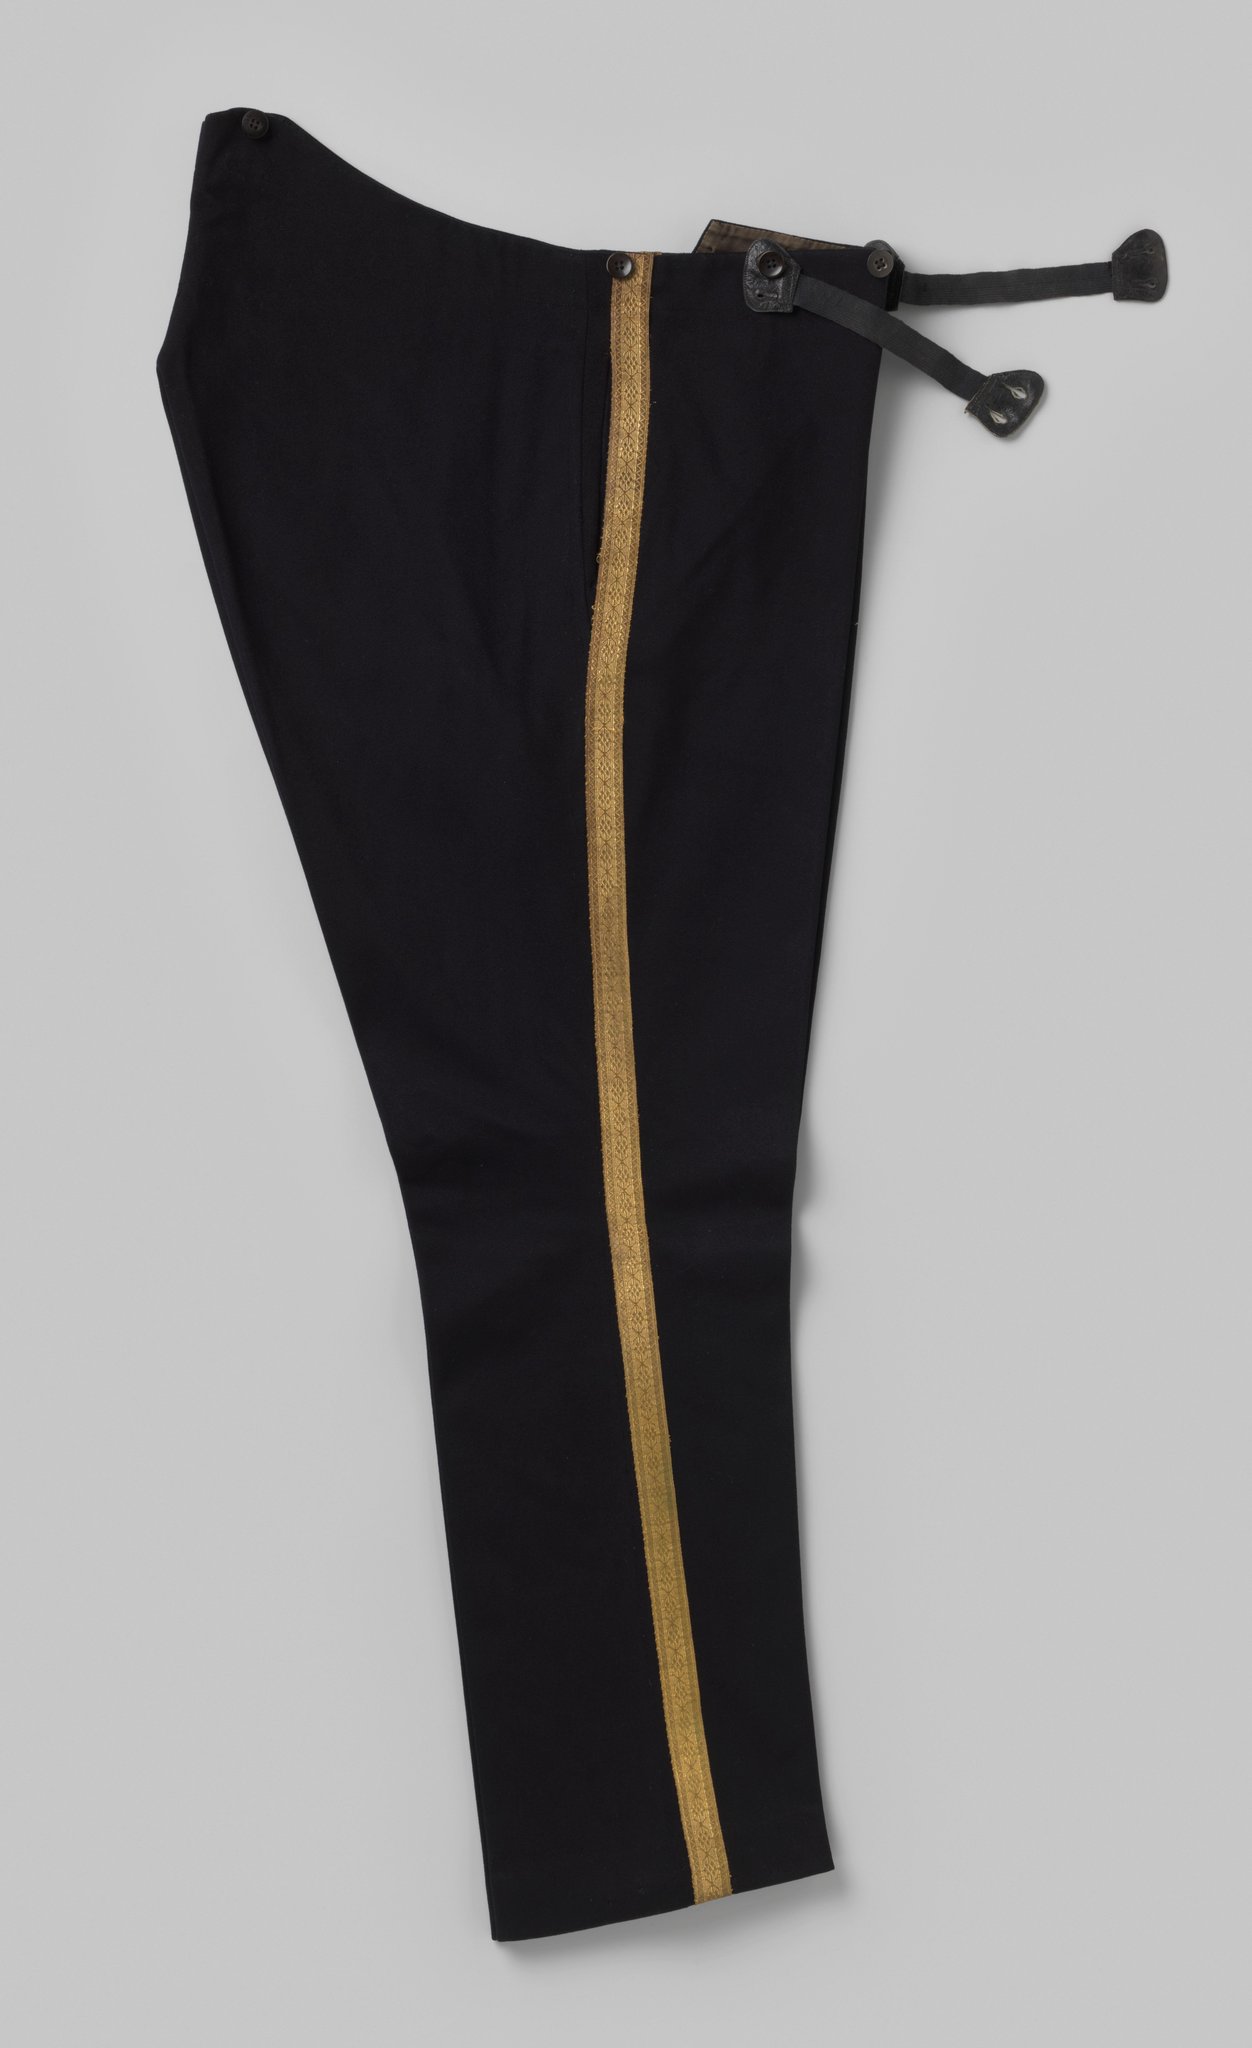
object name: pantalon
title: Broek van gala-kostuum van lid Erewacht tijdens de inhuldiging van koningin Juliana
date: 1909-1948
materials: textile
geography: netherlands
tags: erich hartmann, the hague, juliana of the netherlands, amsterdam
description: Zwarte pantalon met goudgalon en diverse gladde zwarte knopen. Broek deels gevoerd met zwarte zijde. Gedragen door Ernst Hartmann, lid Erewacht, tijdens de inhuldiging van koningin Juliana op 6 september 1948.